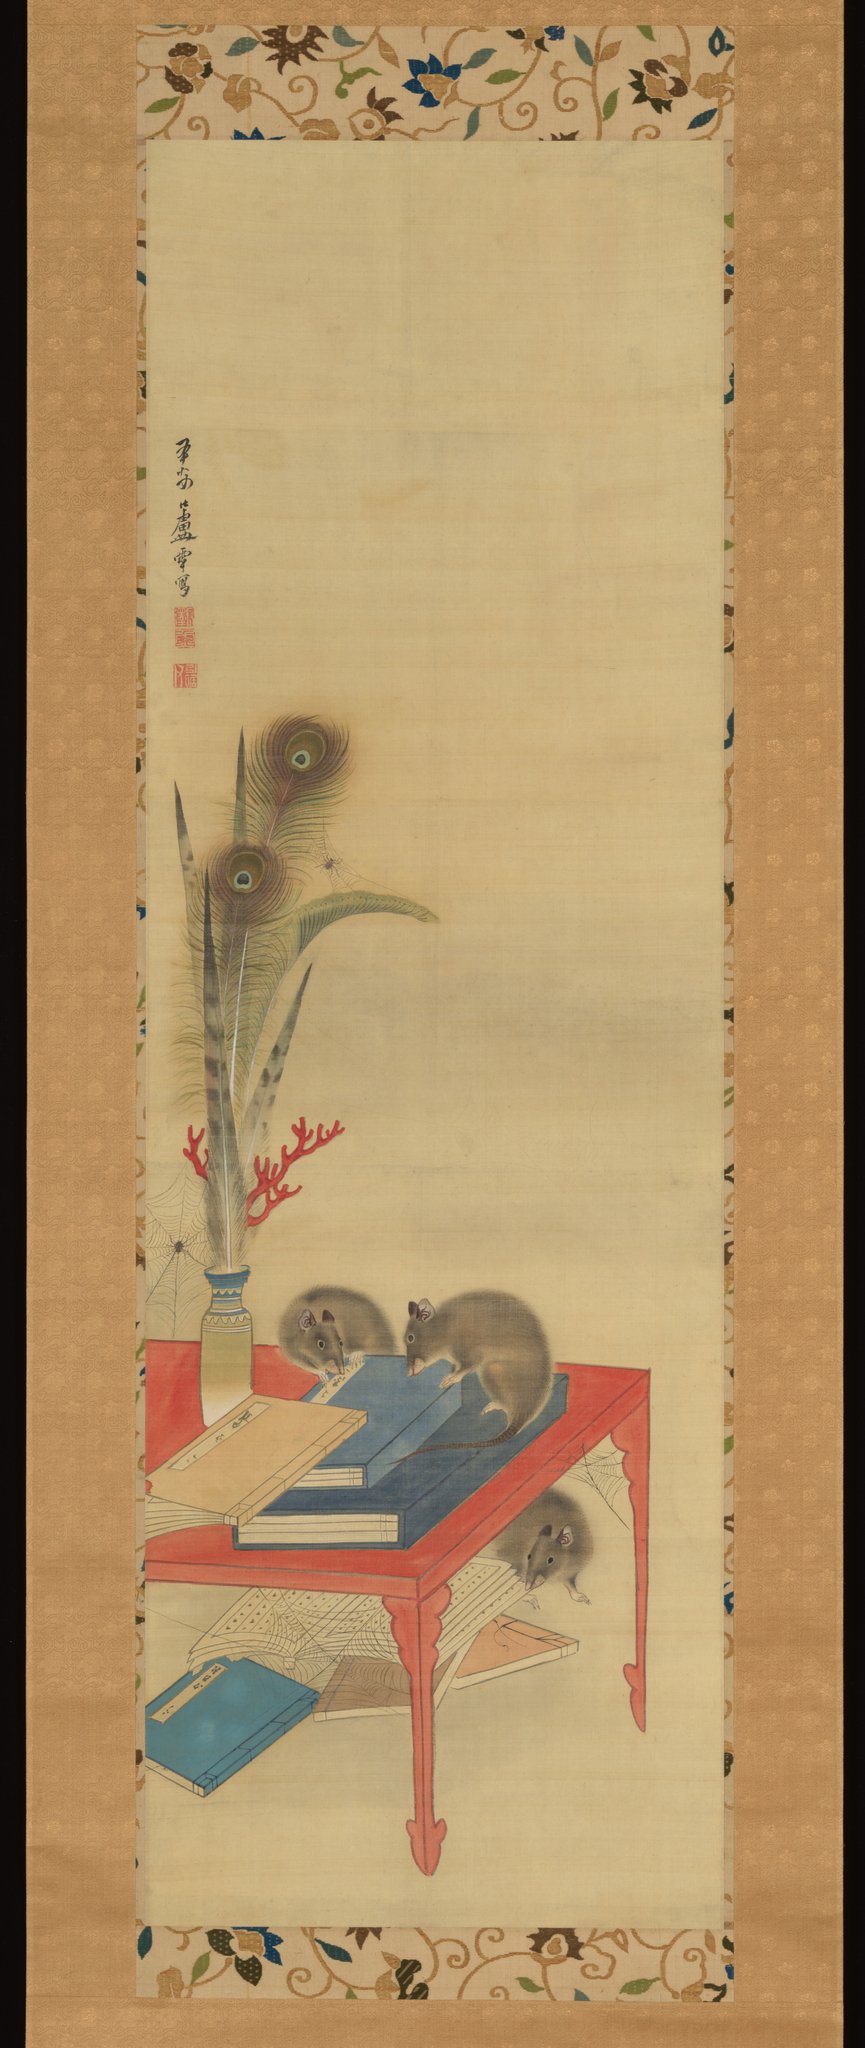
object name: hanging scroll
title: Rats on a Scholar’s Desk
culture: japanese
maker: nagasawa rosetsu 長澤蘆雪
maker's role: artist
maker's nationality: japanese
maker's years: 1754-1799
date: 1794-1795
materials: ink, silk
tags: books,rats,desks